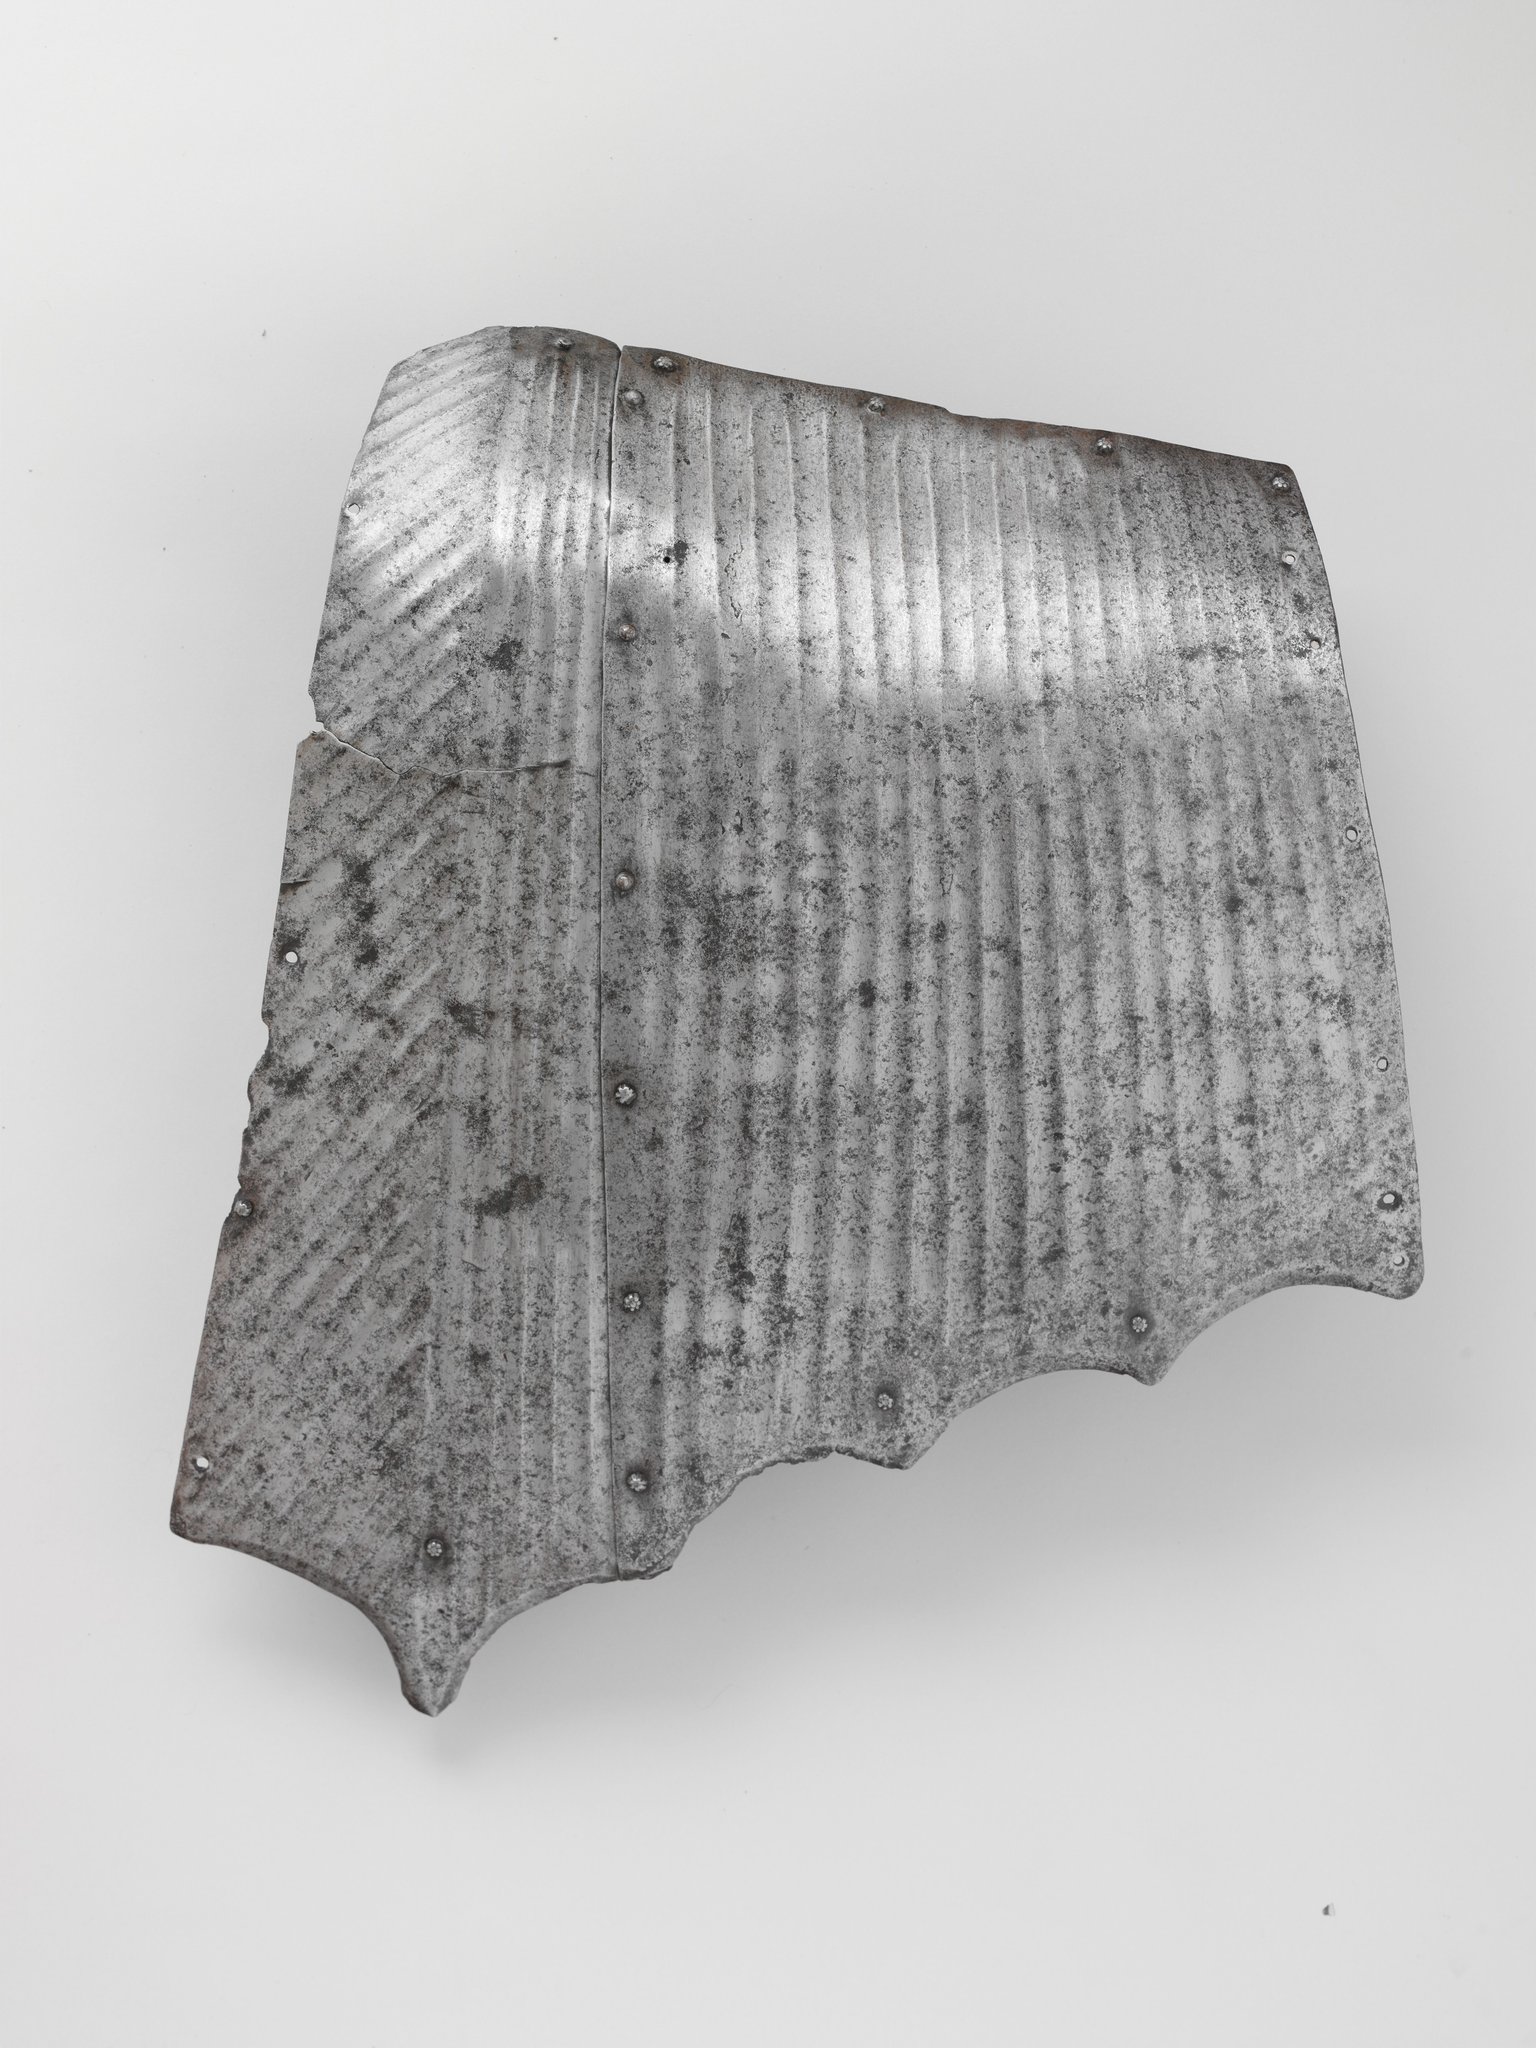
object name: side panel of a crupper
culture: german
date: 1485-1500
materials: steel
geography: germany